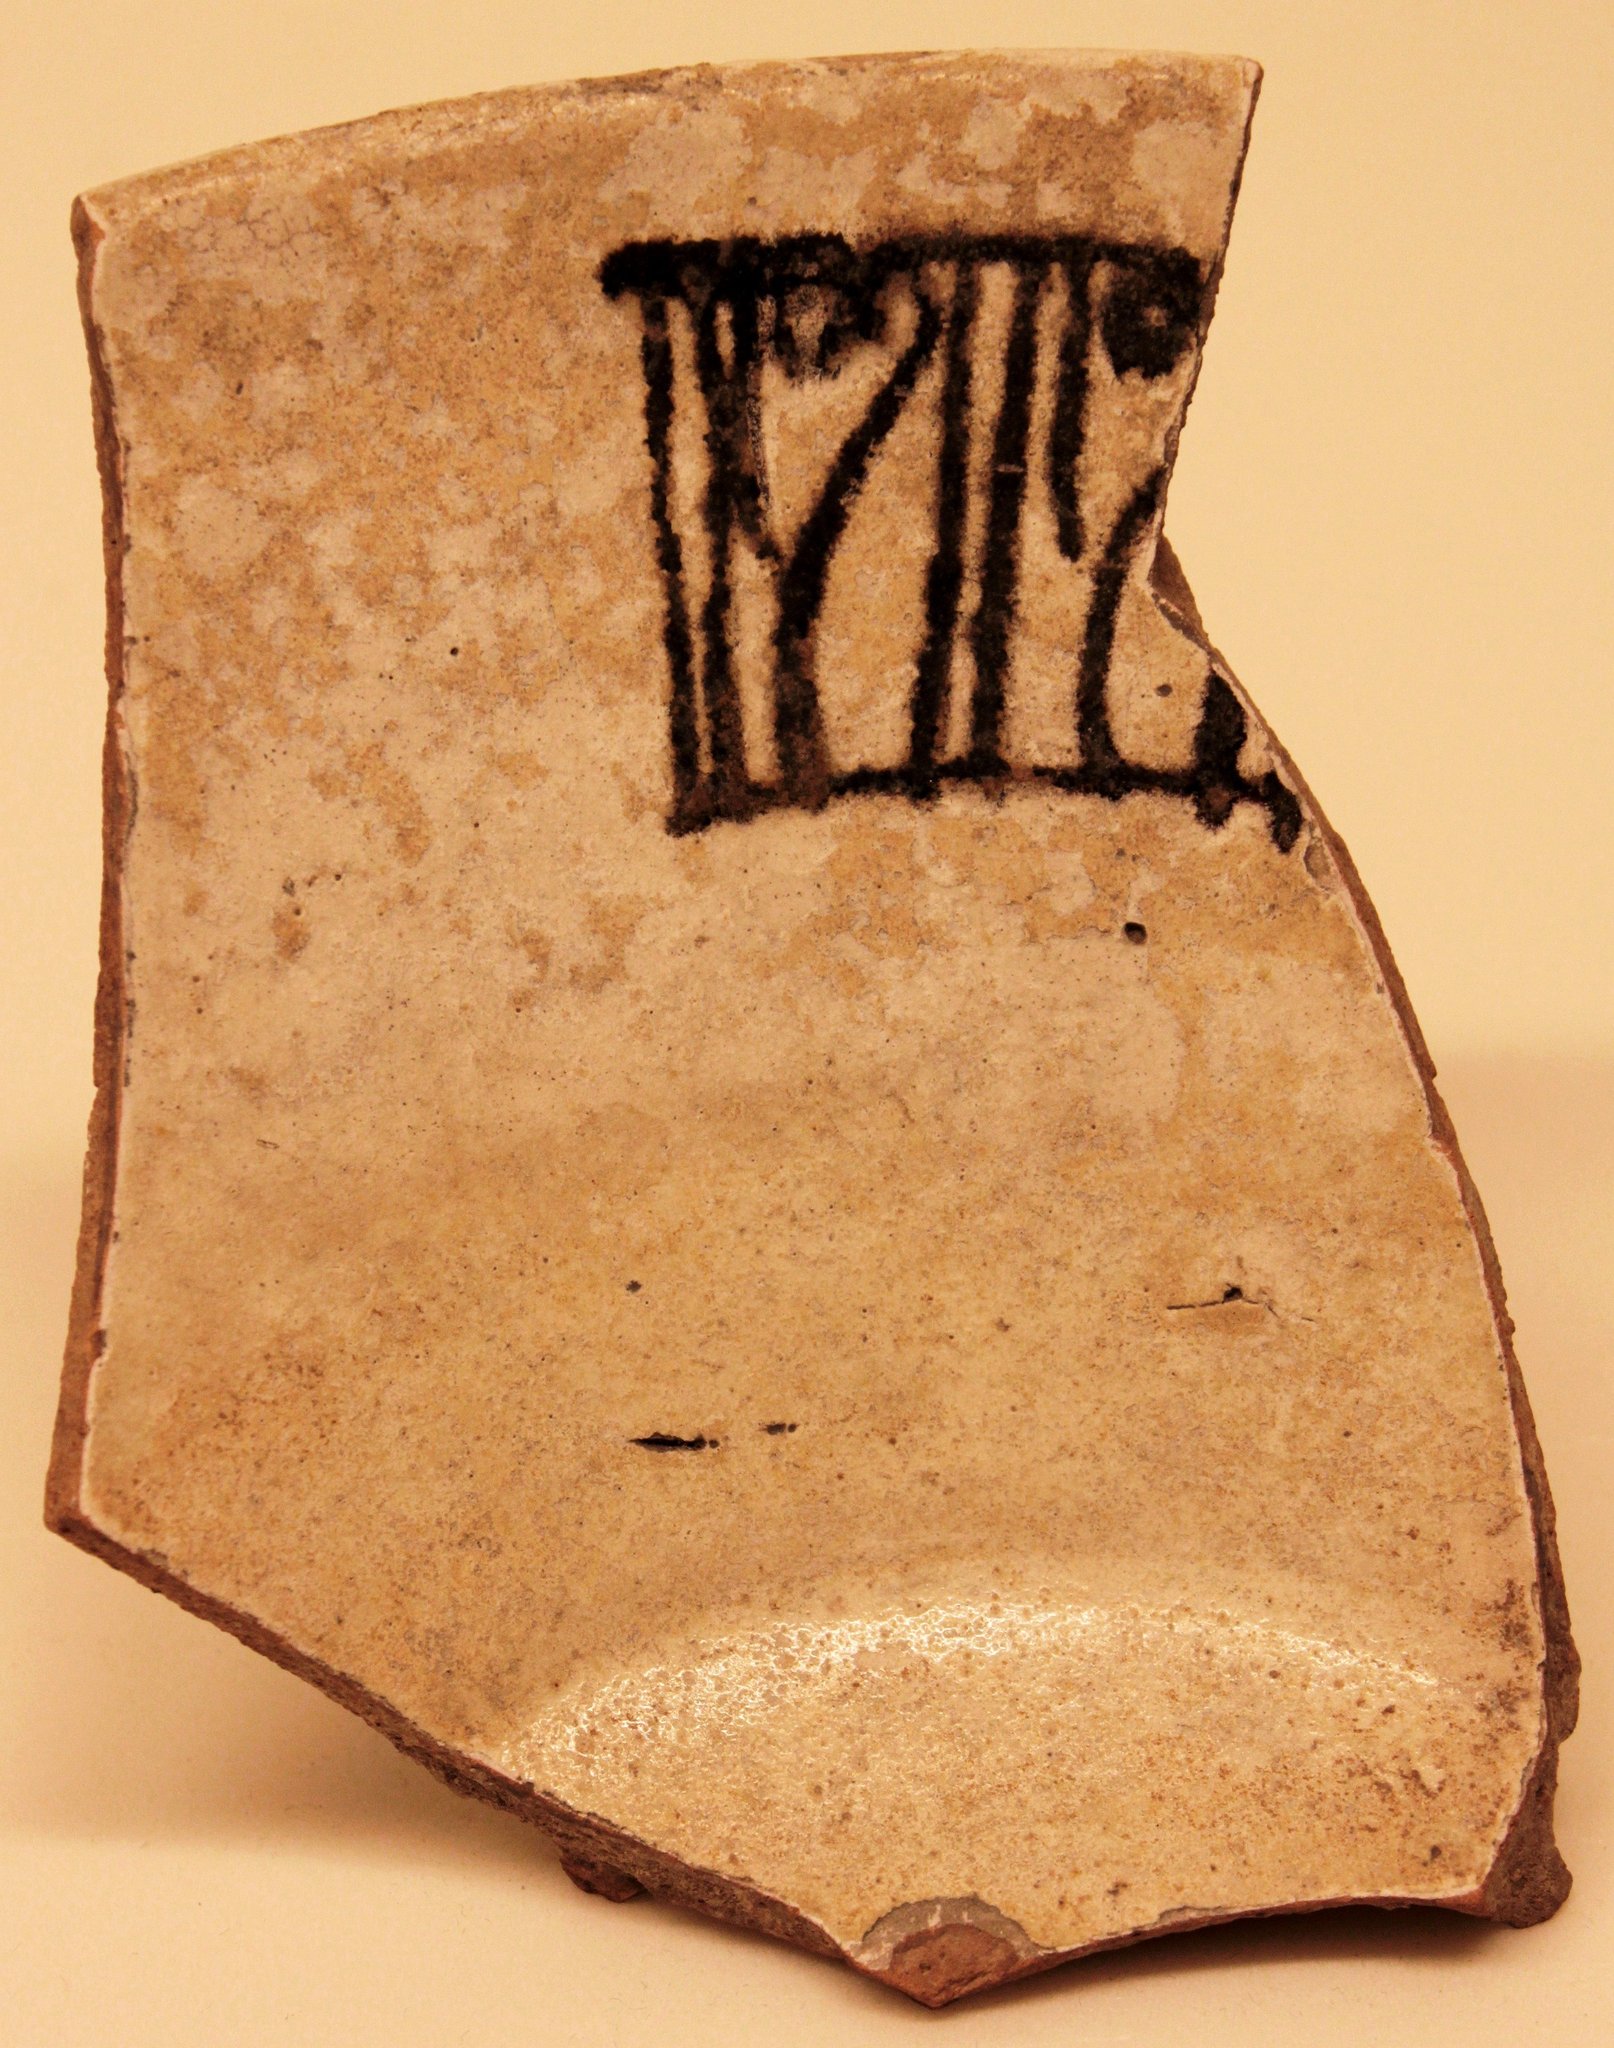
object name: fragment of a bowl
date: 967-1100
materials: earthenware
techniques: glazing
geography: iran